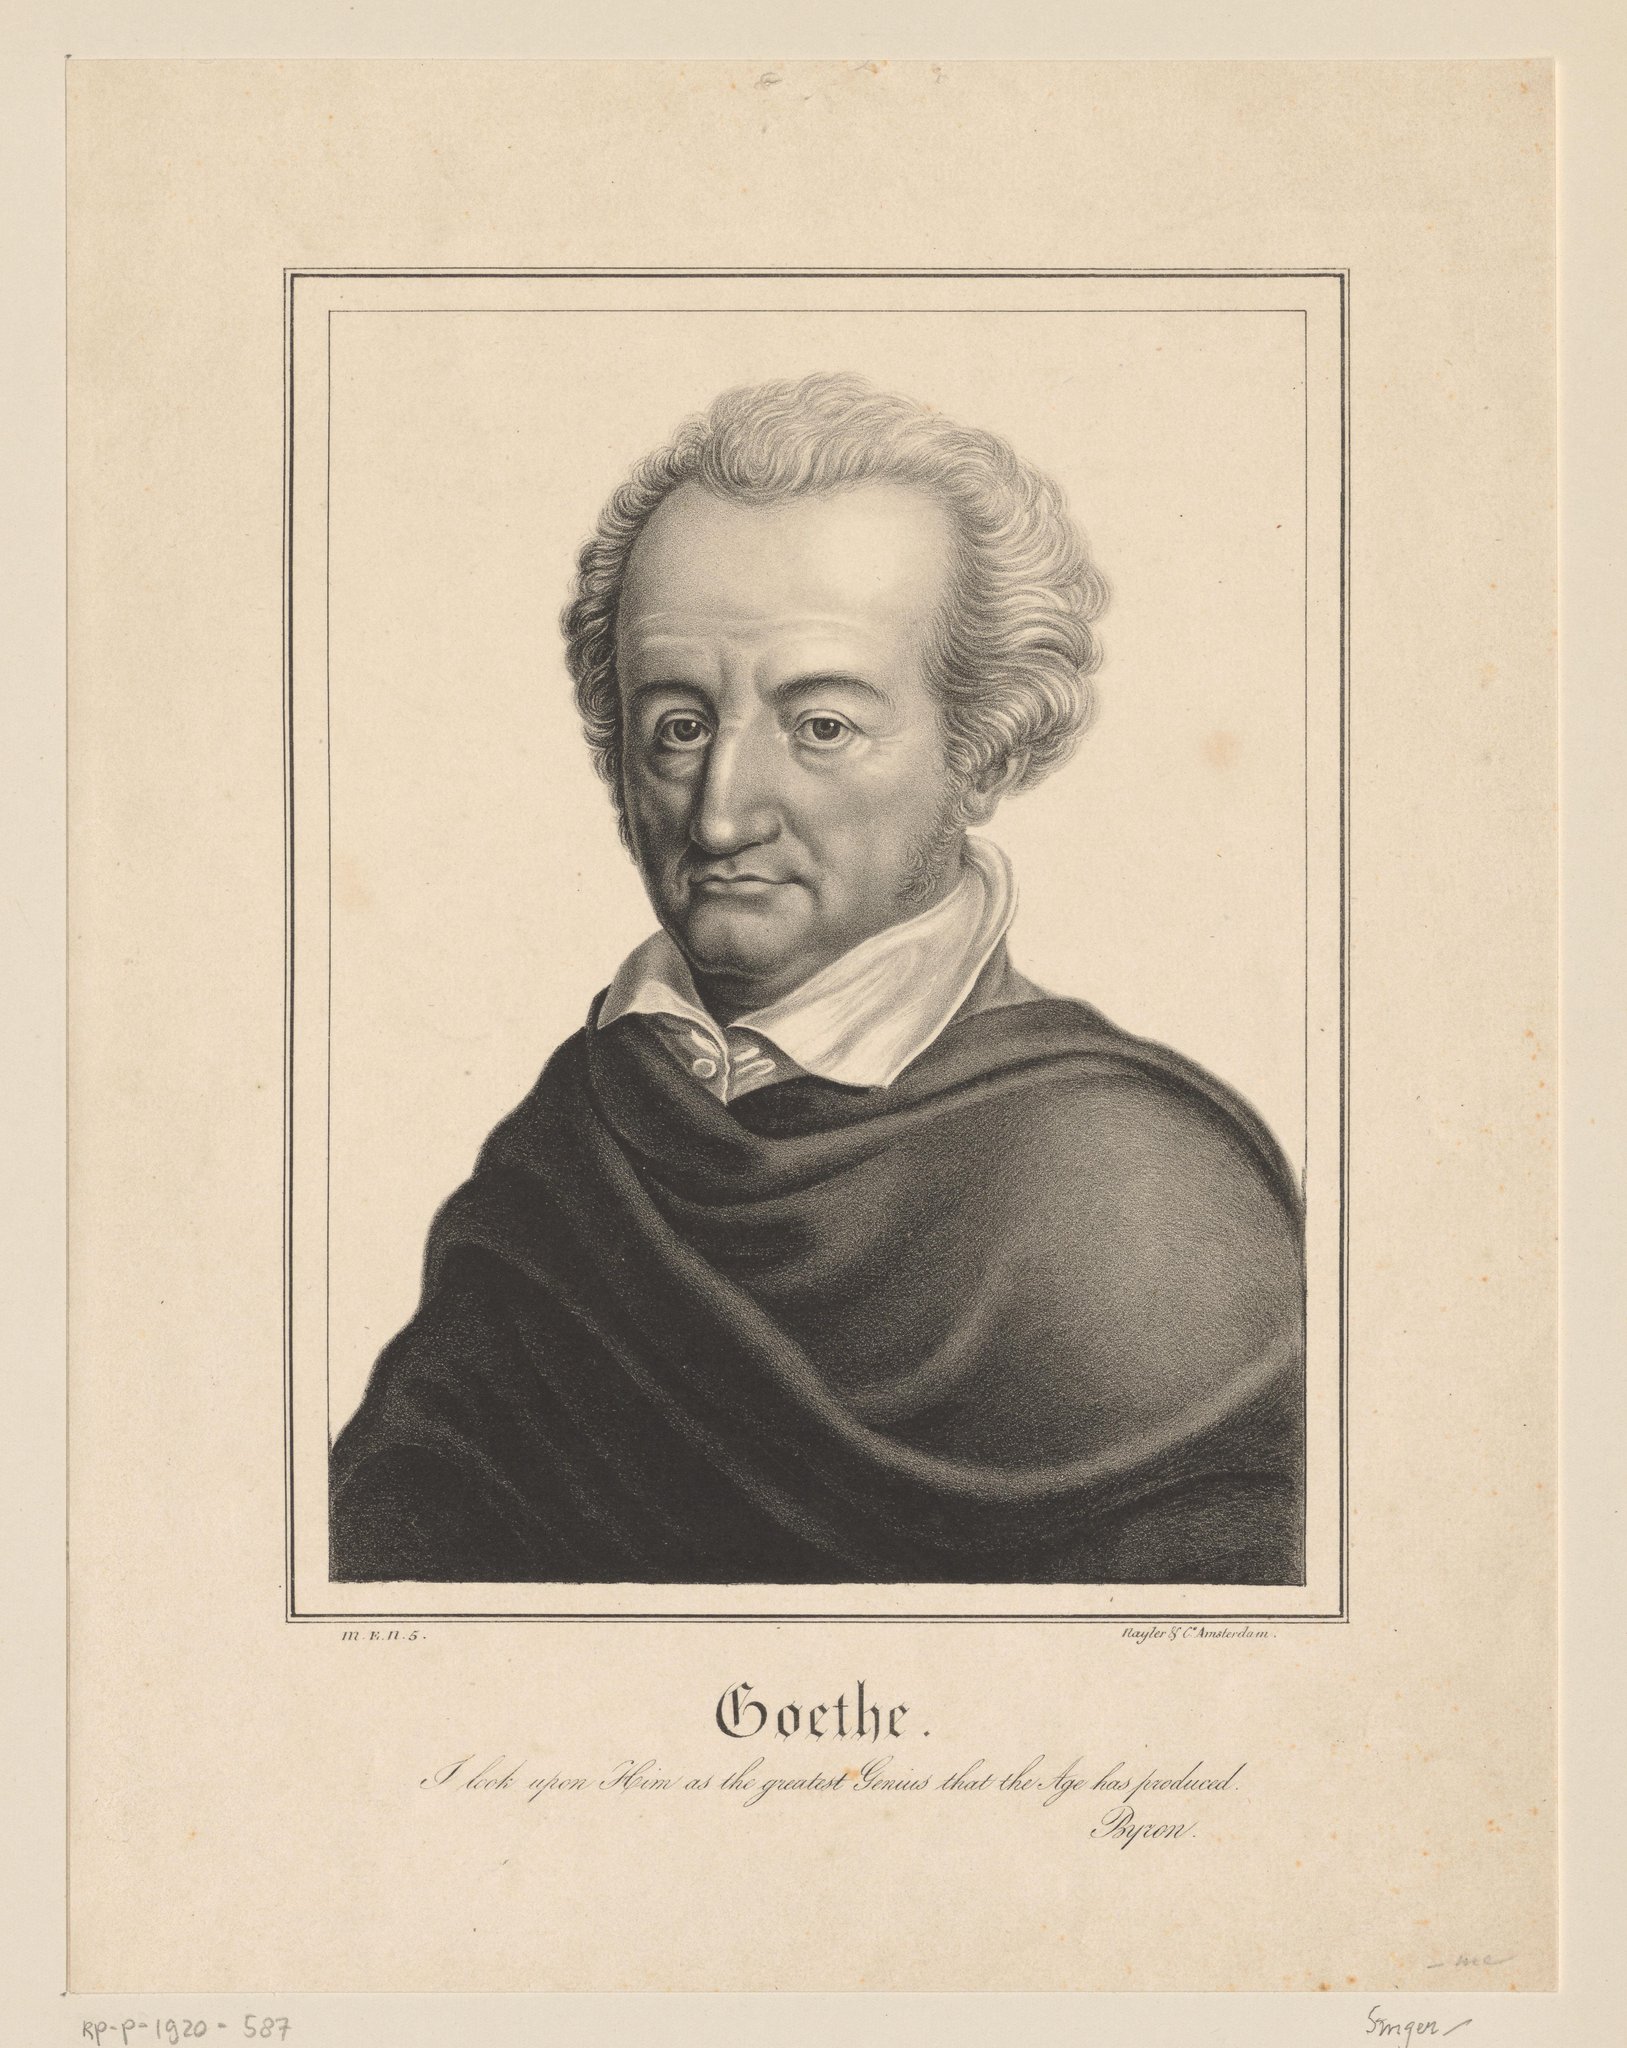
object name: print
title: Portret van Johann Wolfgang von Goethe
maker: maria elisabeth liernur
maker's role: print maker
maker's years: 1802-1874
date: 1831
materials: paper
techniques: lithograph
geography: amsterdam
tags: draughtsman, johann wolfgang von goethe, historical persons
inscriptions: collector's mark: Lugt 2228